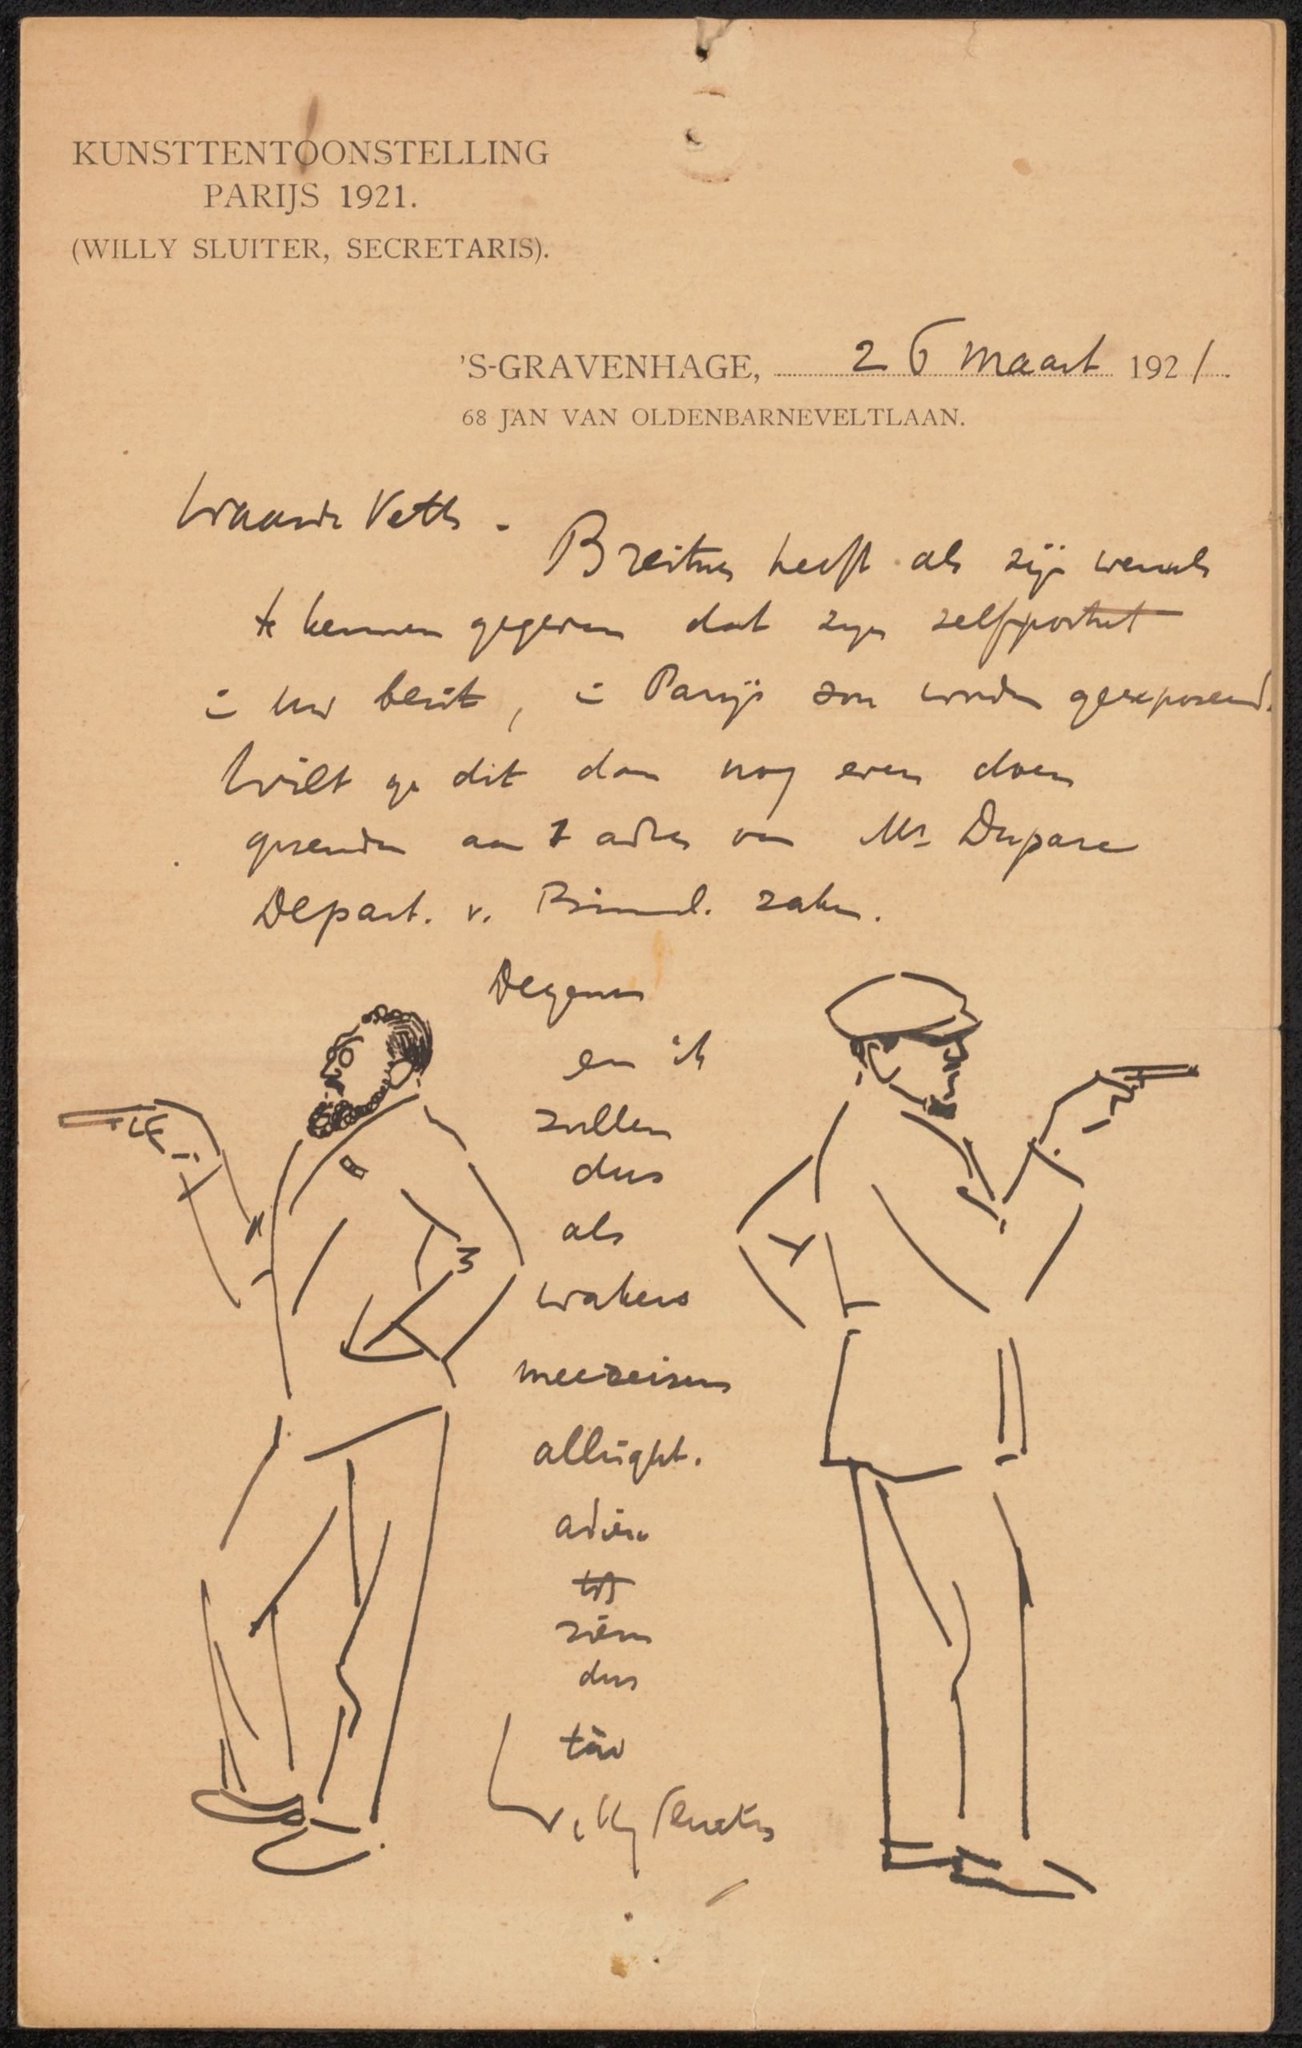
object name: letter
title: Brief aan Jan Veth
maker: willy sluiter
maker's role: draughtsman, painter, print maker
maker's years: 1873-1949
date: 1921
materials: ink, paper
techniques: pen, printing, writing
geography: the hague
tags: rotterdam, amsterdam, painter, print maker, draughtsman, george hendrik breitner, dordrecht, designer, jan veth, frederik schmidt-degener, paris, mozes isaac duparc, guarding of treasure by men, exhibition ~ art, historical persons (portraits and scenes from the life)